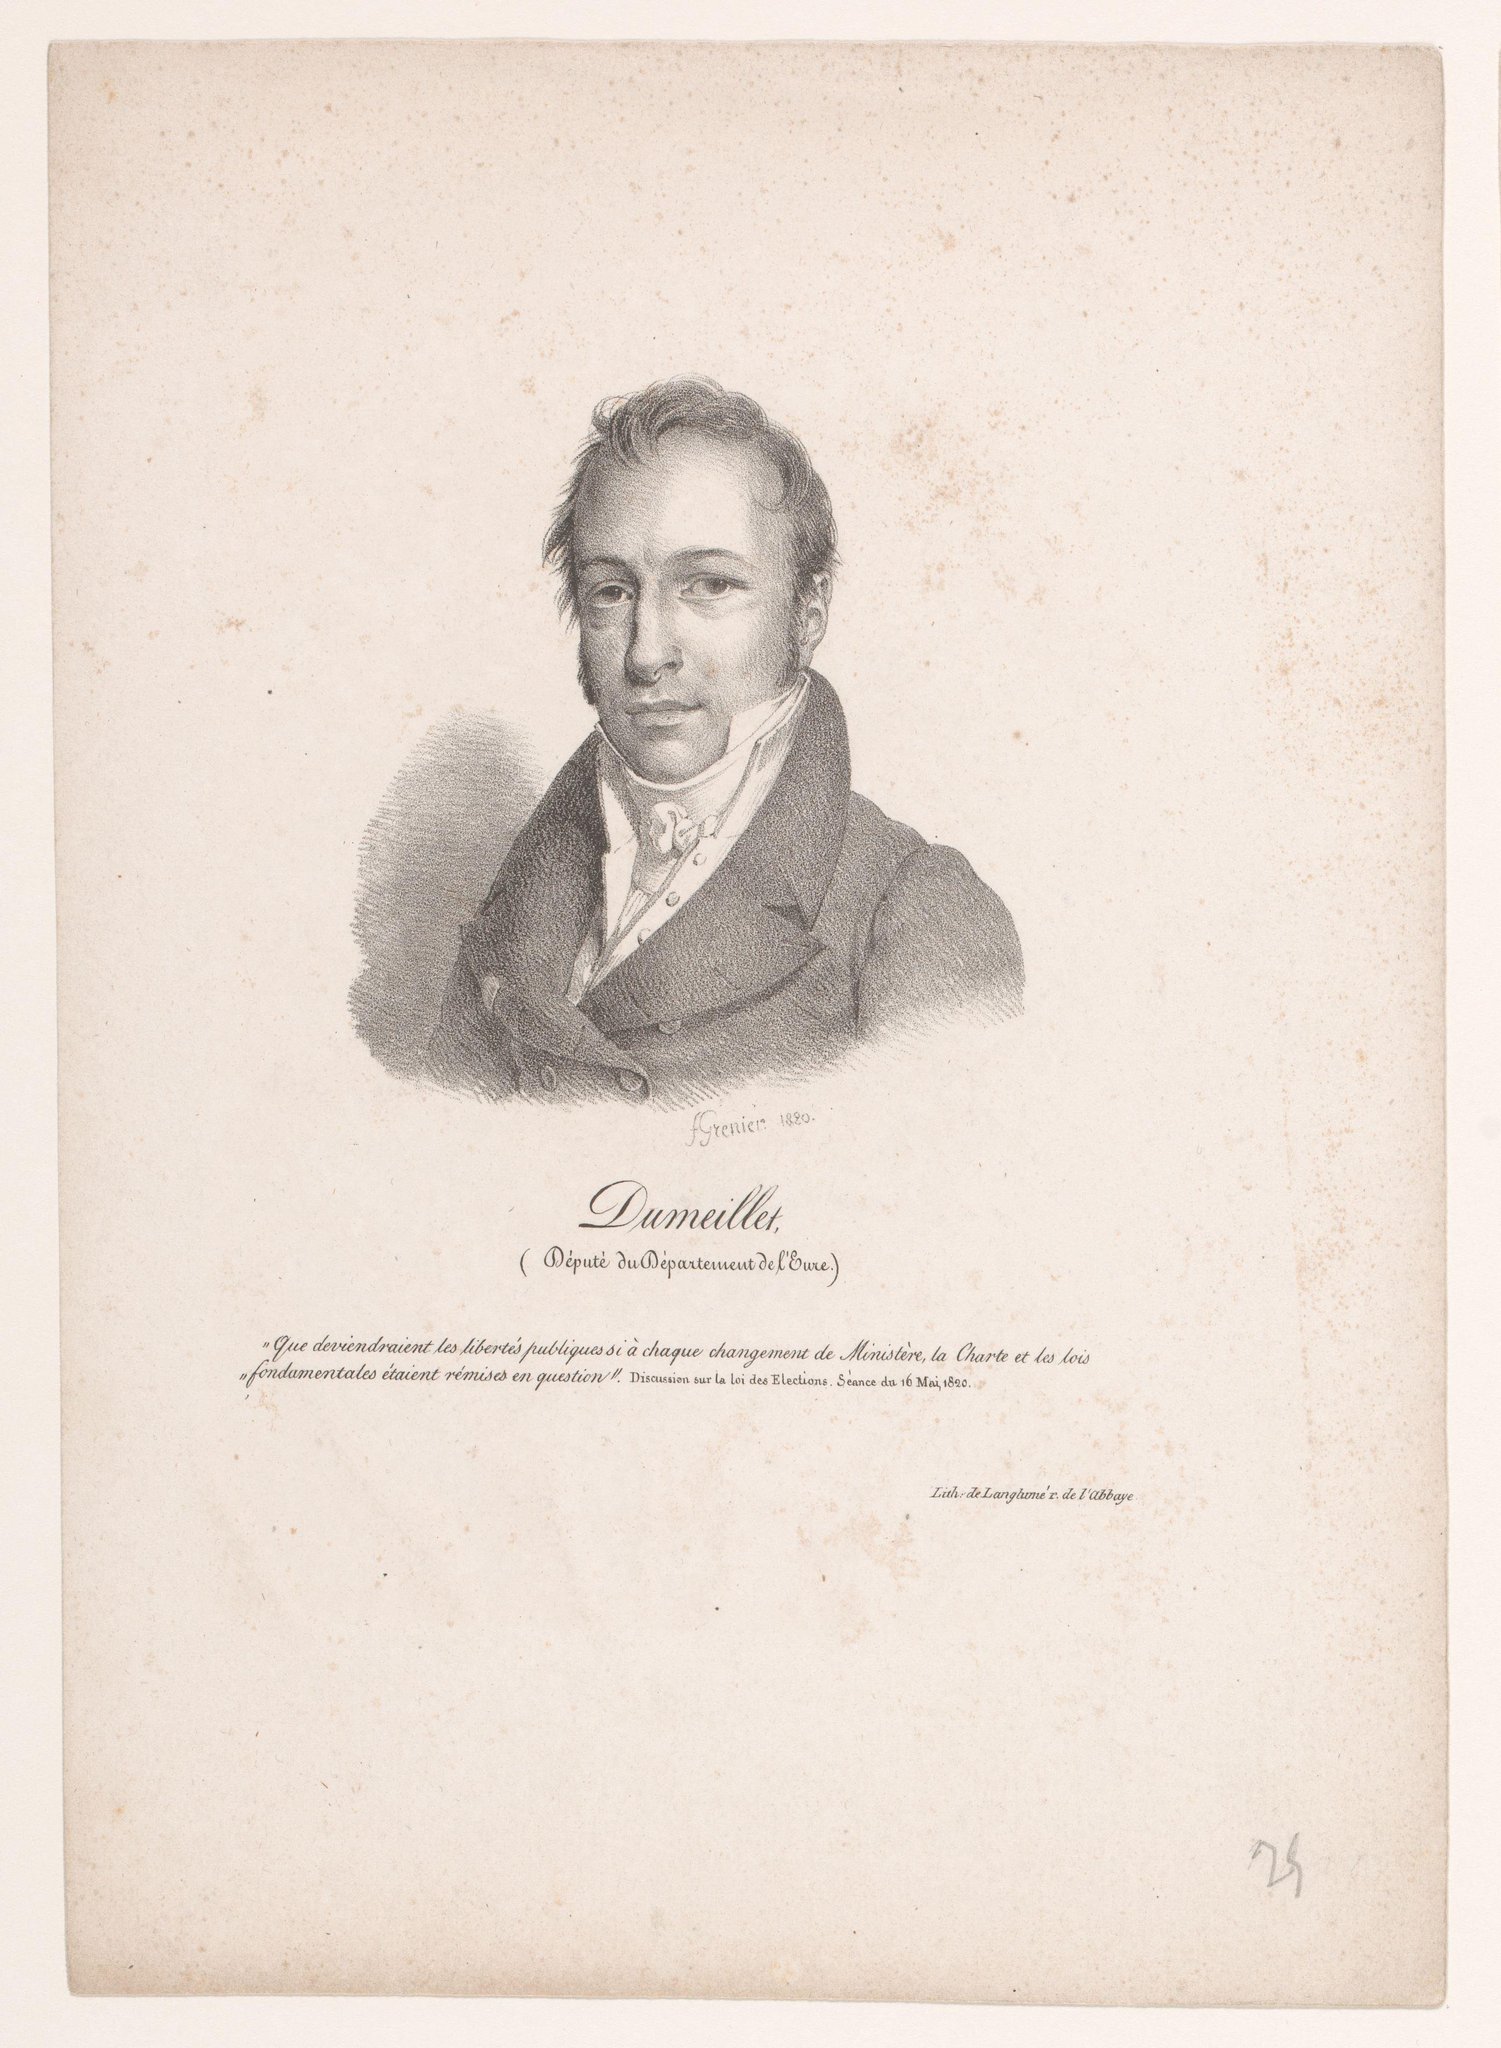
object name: print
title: Afgevaardigden in de Nationale Vergadering 1820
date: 1820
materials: paper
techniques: lithograph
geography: paris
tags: politician, historical persons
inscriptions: collector's mark: Lugt 2228a